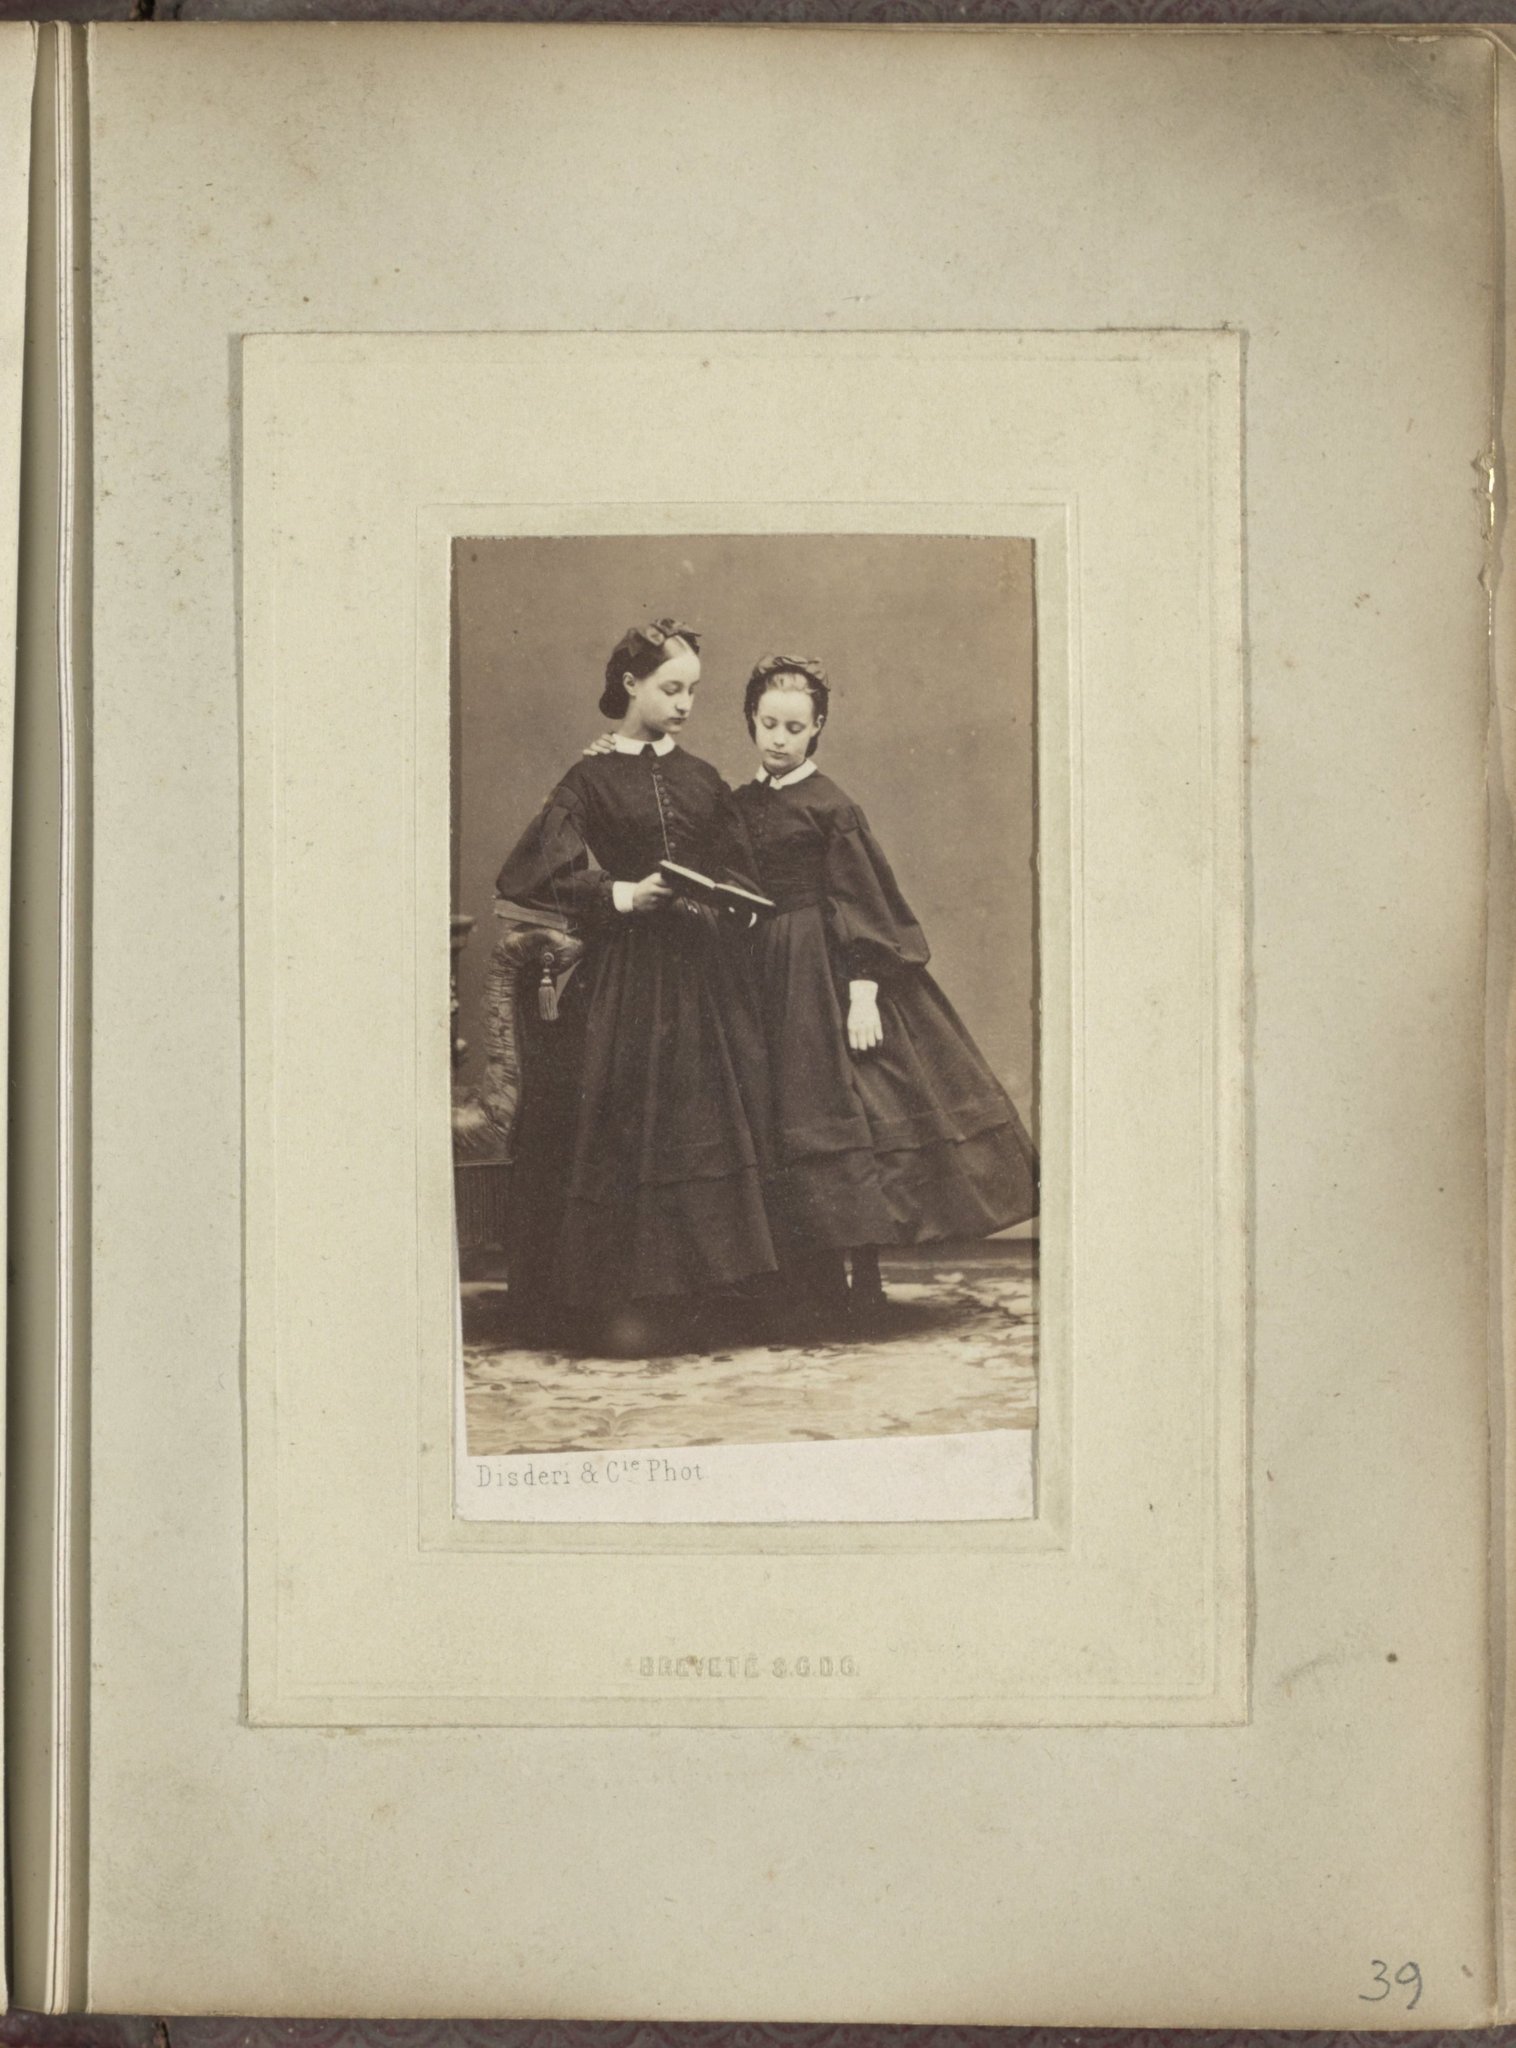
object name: photograph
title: Portret van twee zusjes De Beaulaincourt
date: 1860-1865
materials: cardboard, paper, photographic support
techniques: albumen print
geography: paris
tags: studio requisites ~ photographer, child, historical persons, styles of hairdress - aa - ~ women, book, dress, gown, brothers or sisters (second degree family relationships), paris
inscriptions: name: ‘[...] de Beaulaincourt’, address: ‘8, Boulevart des Italiens, Paris’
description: Onderdeel van Fotoalbum met 48 cartes-de-visite aangeboden aan maarschalk graaf De Castellane.